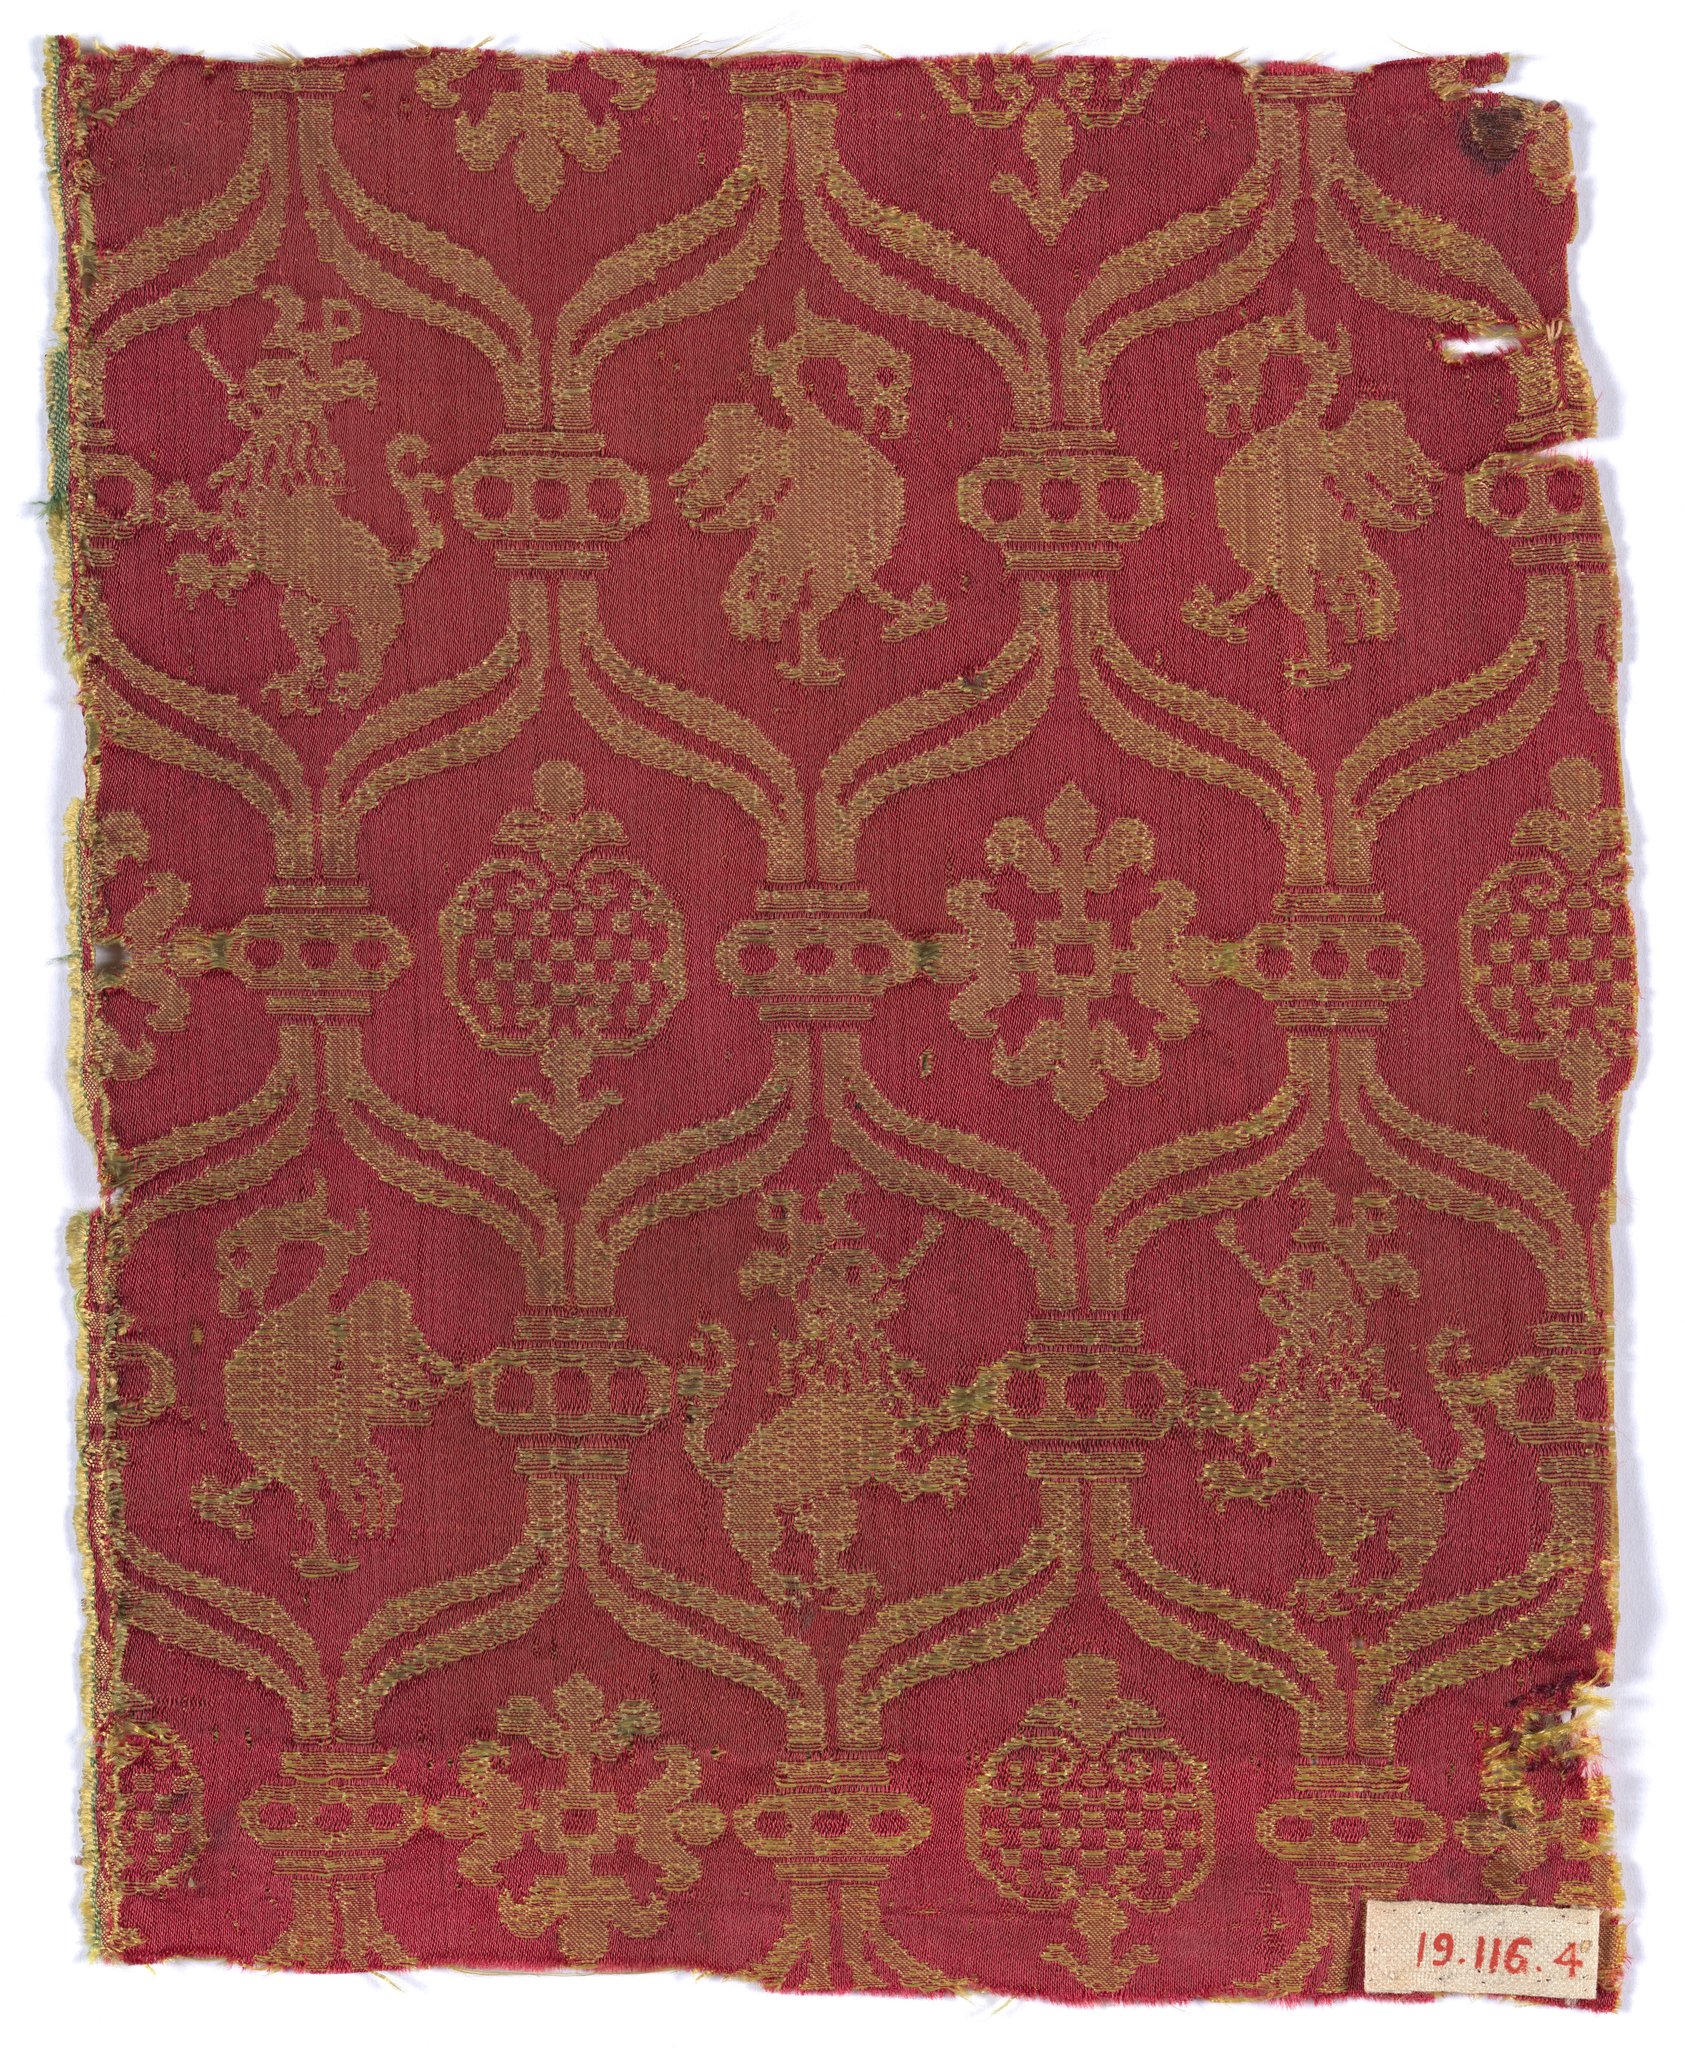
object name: piece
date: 1567-1600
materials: silk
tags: birds,lions